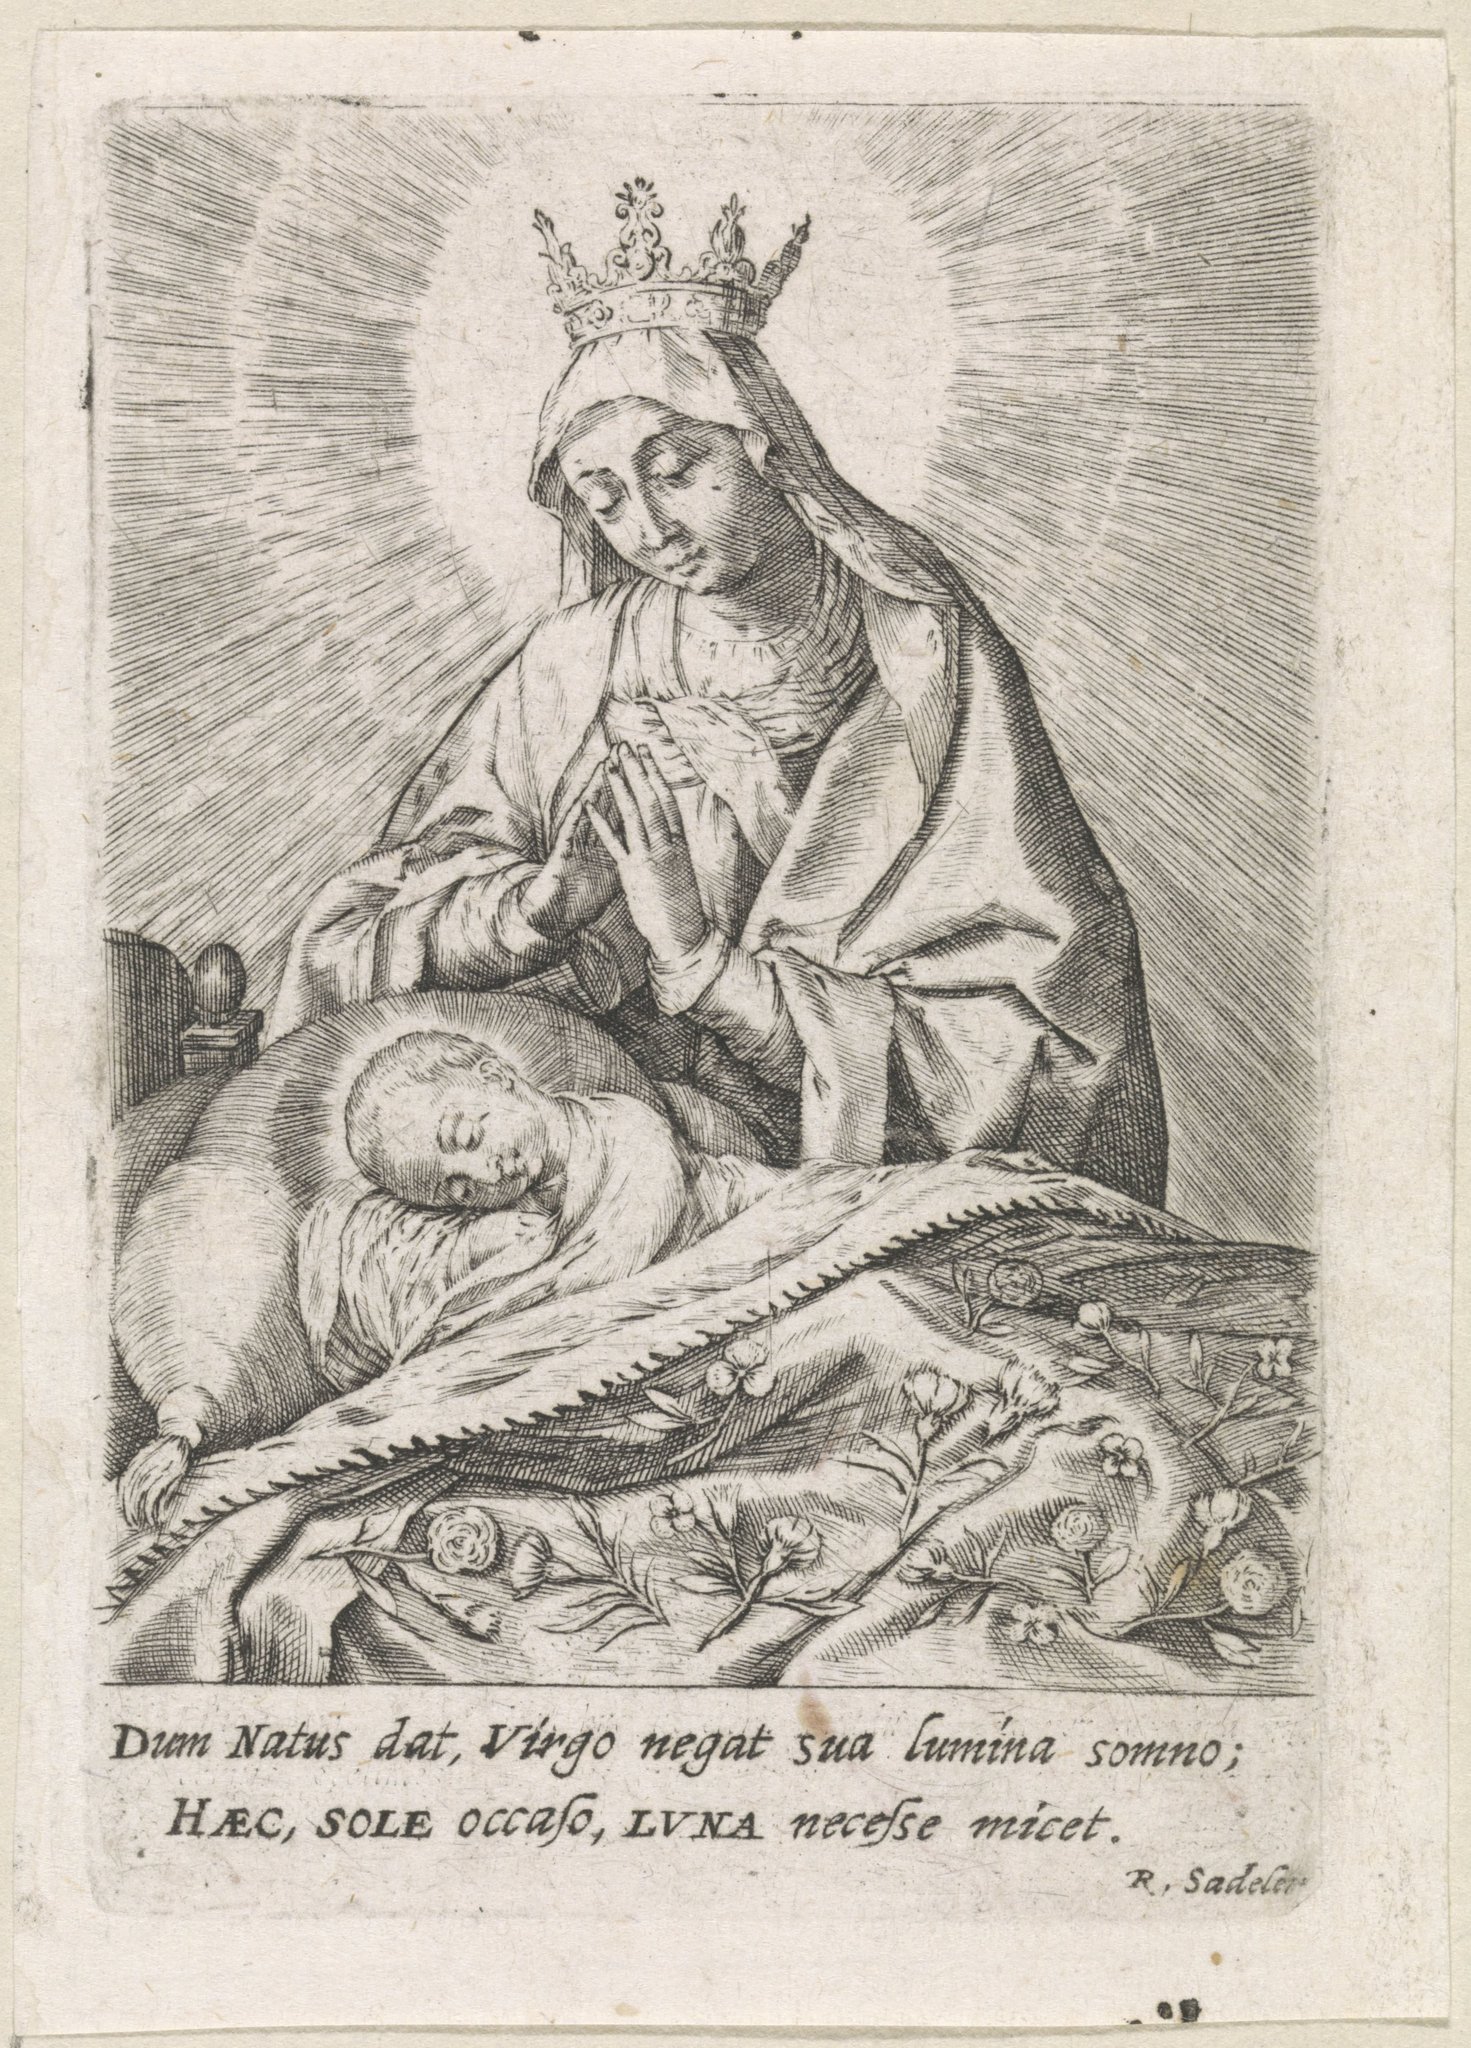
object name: print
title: Slapend Christuskind in bed aanbeden door Maria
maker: anna bergia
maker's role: publisher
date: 1617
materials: paper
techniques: engraving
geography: munich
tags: mary kneeling (on the ground), the christ-child lying in front of her, bed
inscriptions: collector's mark: Lugt 240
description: Prent uit: Ceschi, Matia. Otium spirituale mellifluarum precationum. München: Anna Bergia en Raphaël Sadeler (I) of (II), 1617.